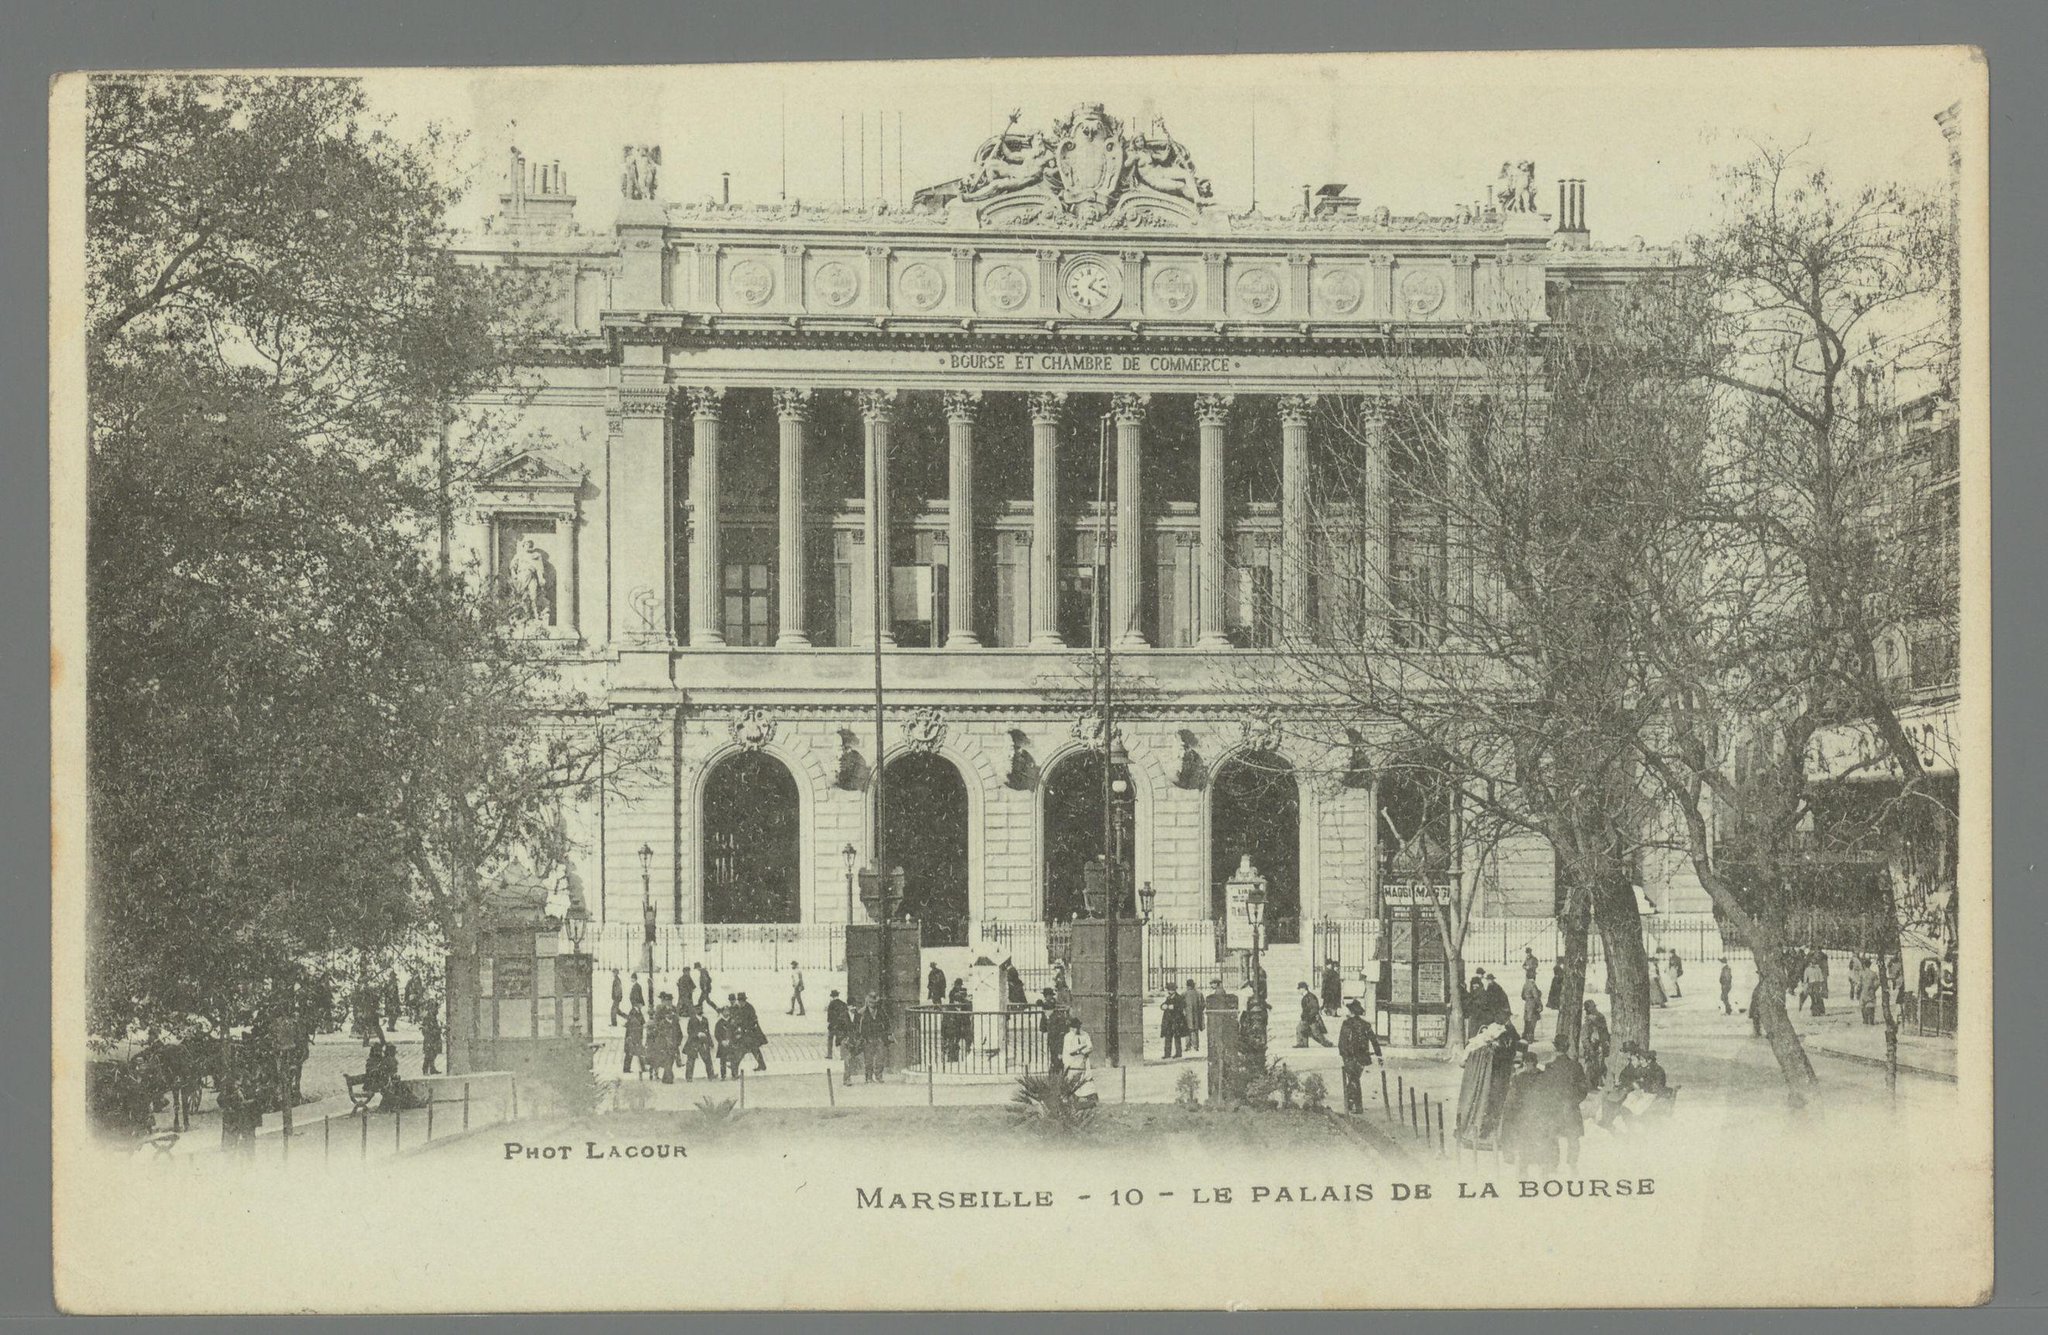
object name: ansichtkaart, prentbriefkaart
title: Marseille (...). Le Palais de la Bourse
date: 1892-1903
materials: cardboard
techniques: photograph, writing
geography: marseille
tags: exchange, bourse, square, place, circus, etc. (+ city(-scape) with figures, staffage), marseille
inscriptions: postage stamp